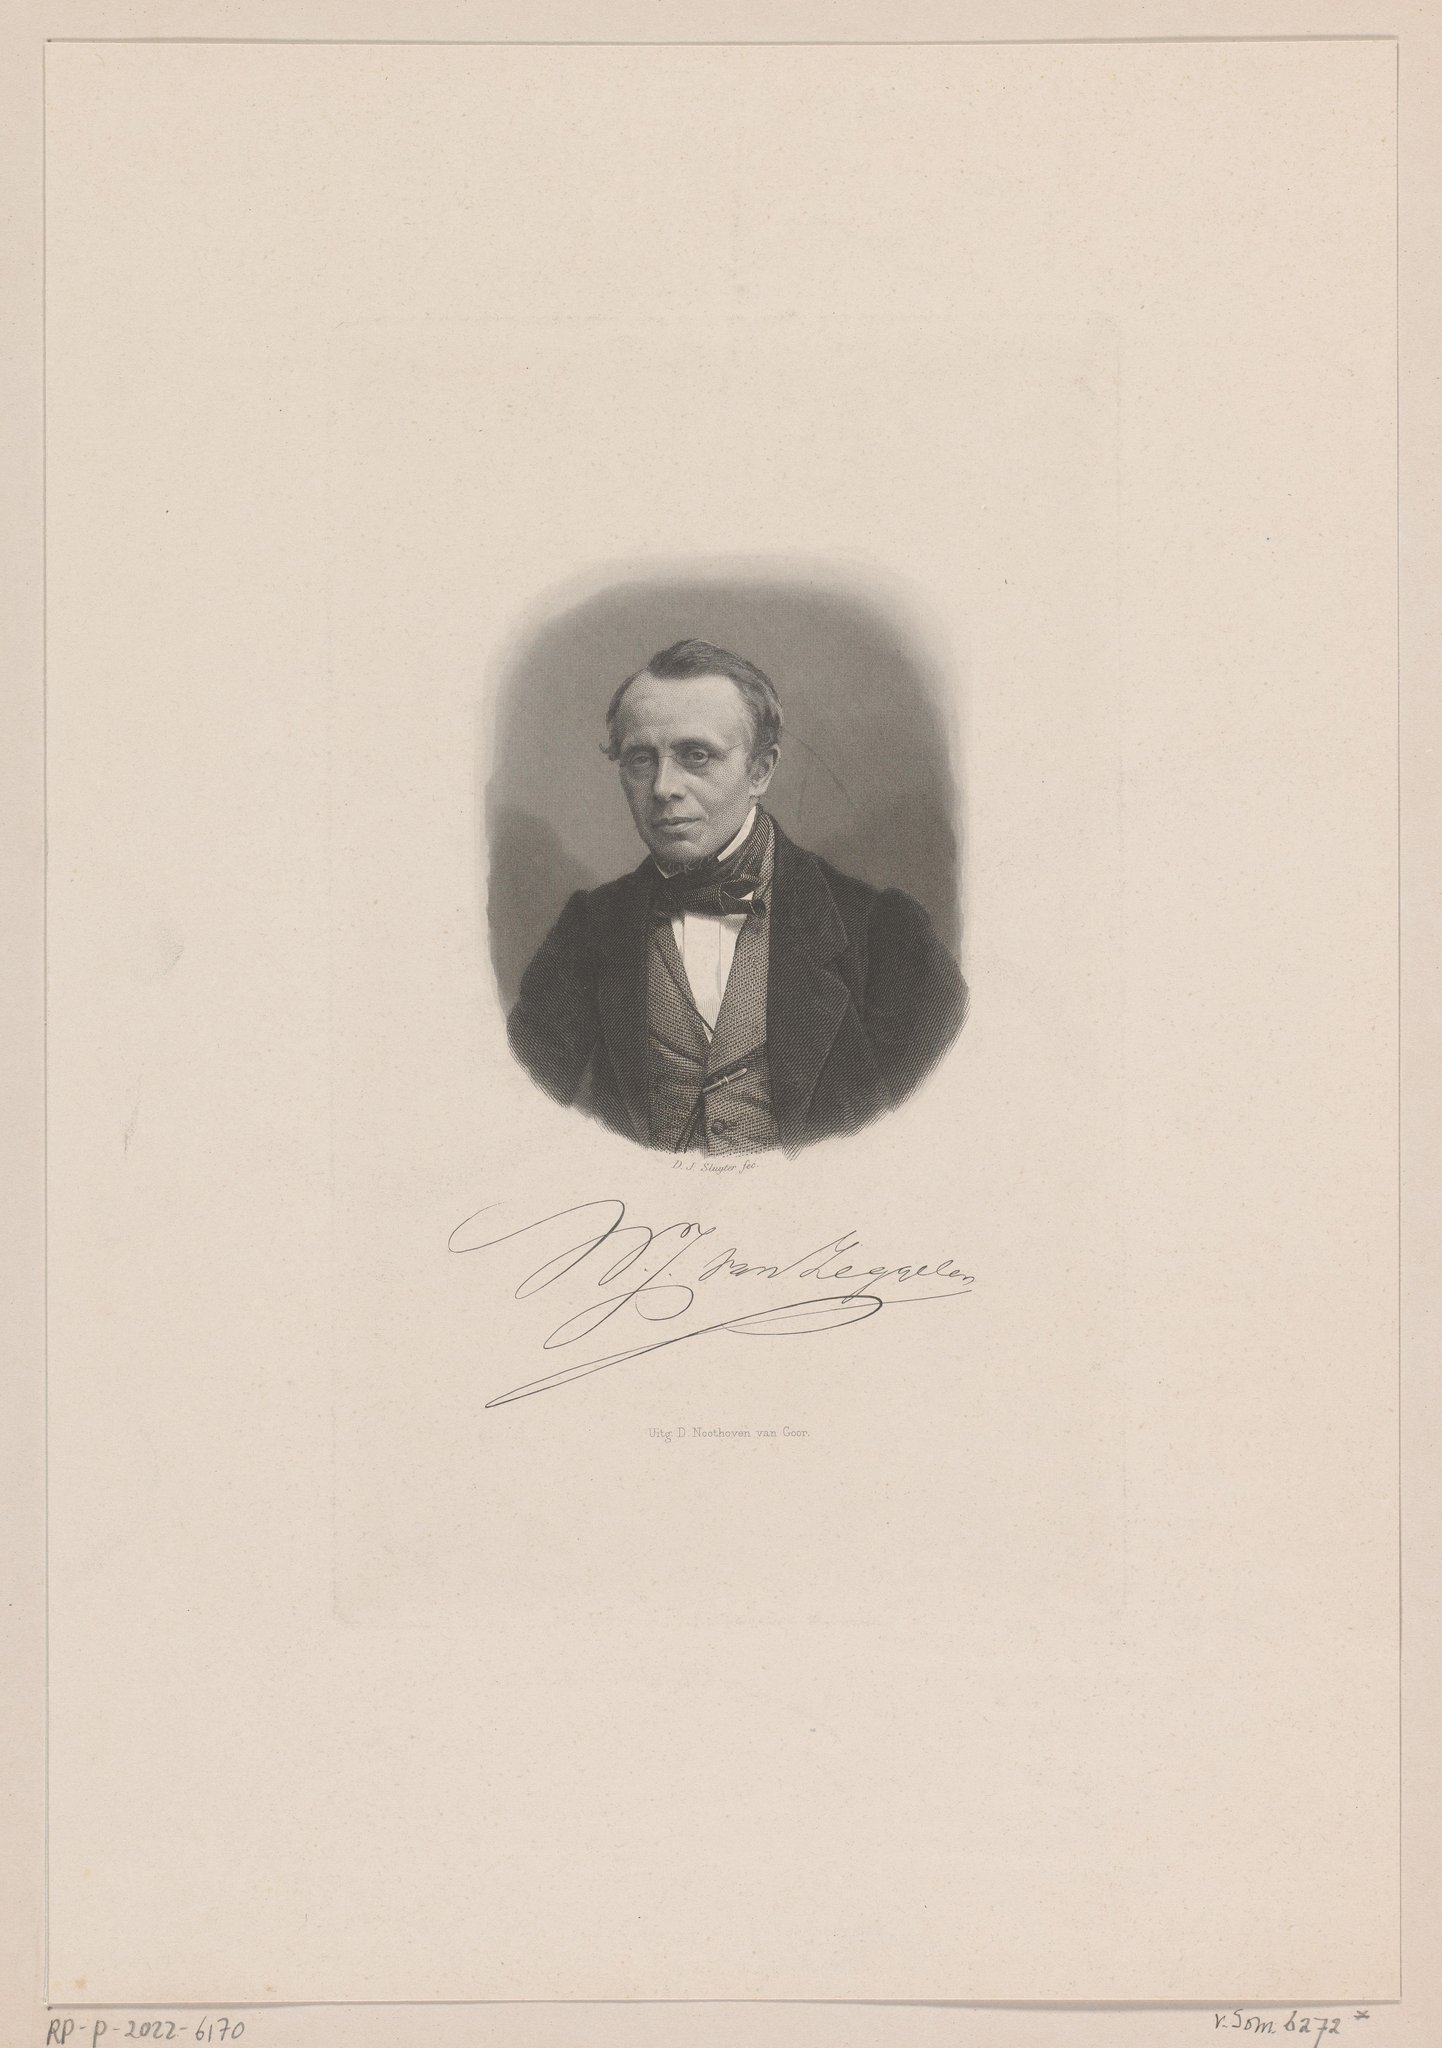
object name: print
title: Portret van Willem Josephus van Zeggelen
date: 1850-1886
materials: paper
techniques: engraving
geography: amsterdam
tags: the hague, historical persons, writer, poet, author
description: Eerste staat van de prent waarschijnlijk uit: Houbraken, Arnold. Toneel van sinnebeelden geopent tot dienst van schilders beelthouders etc.. Dordrecht: Nicolaes de Vries, 1700.